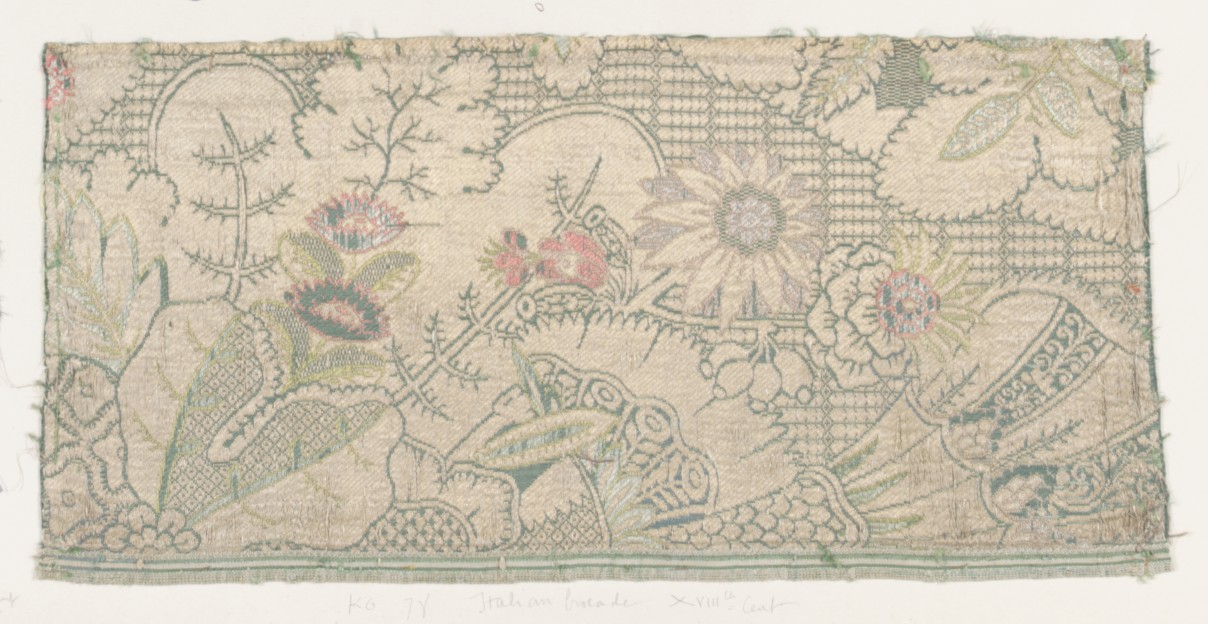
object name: fragment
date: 1701-1800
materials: metal thread, silk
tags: flowers,leaves